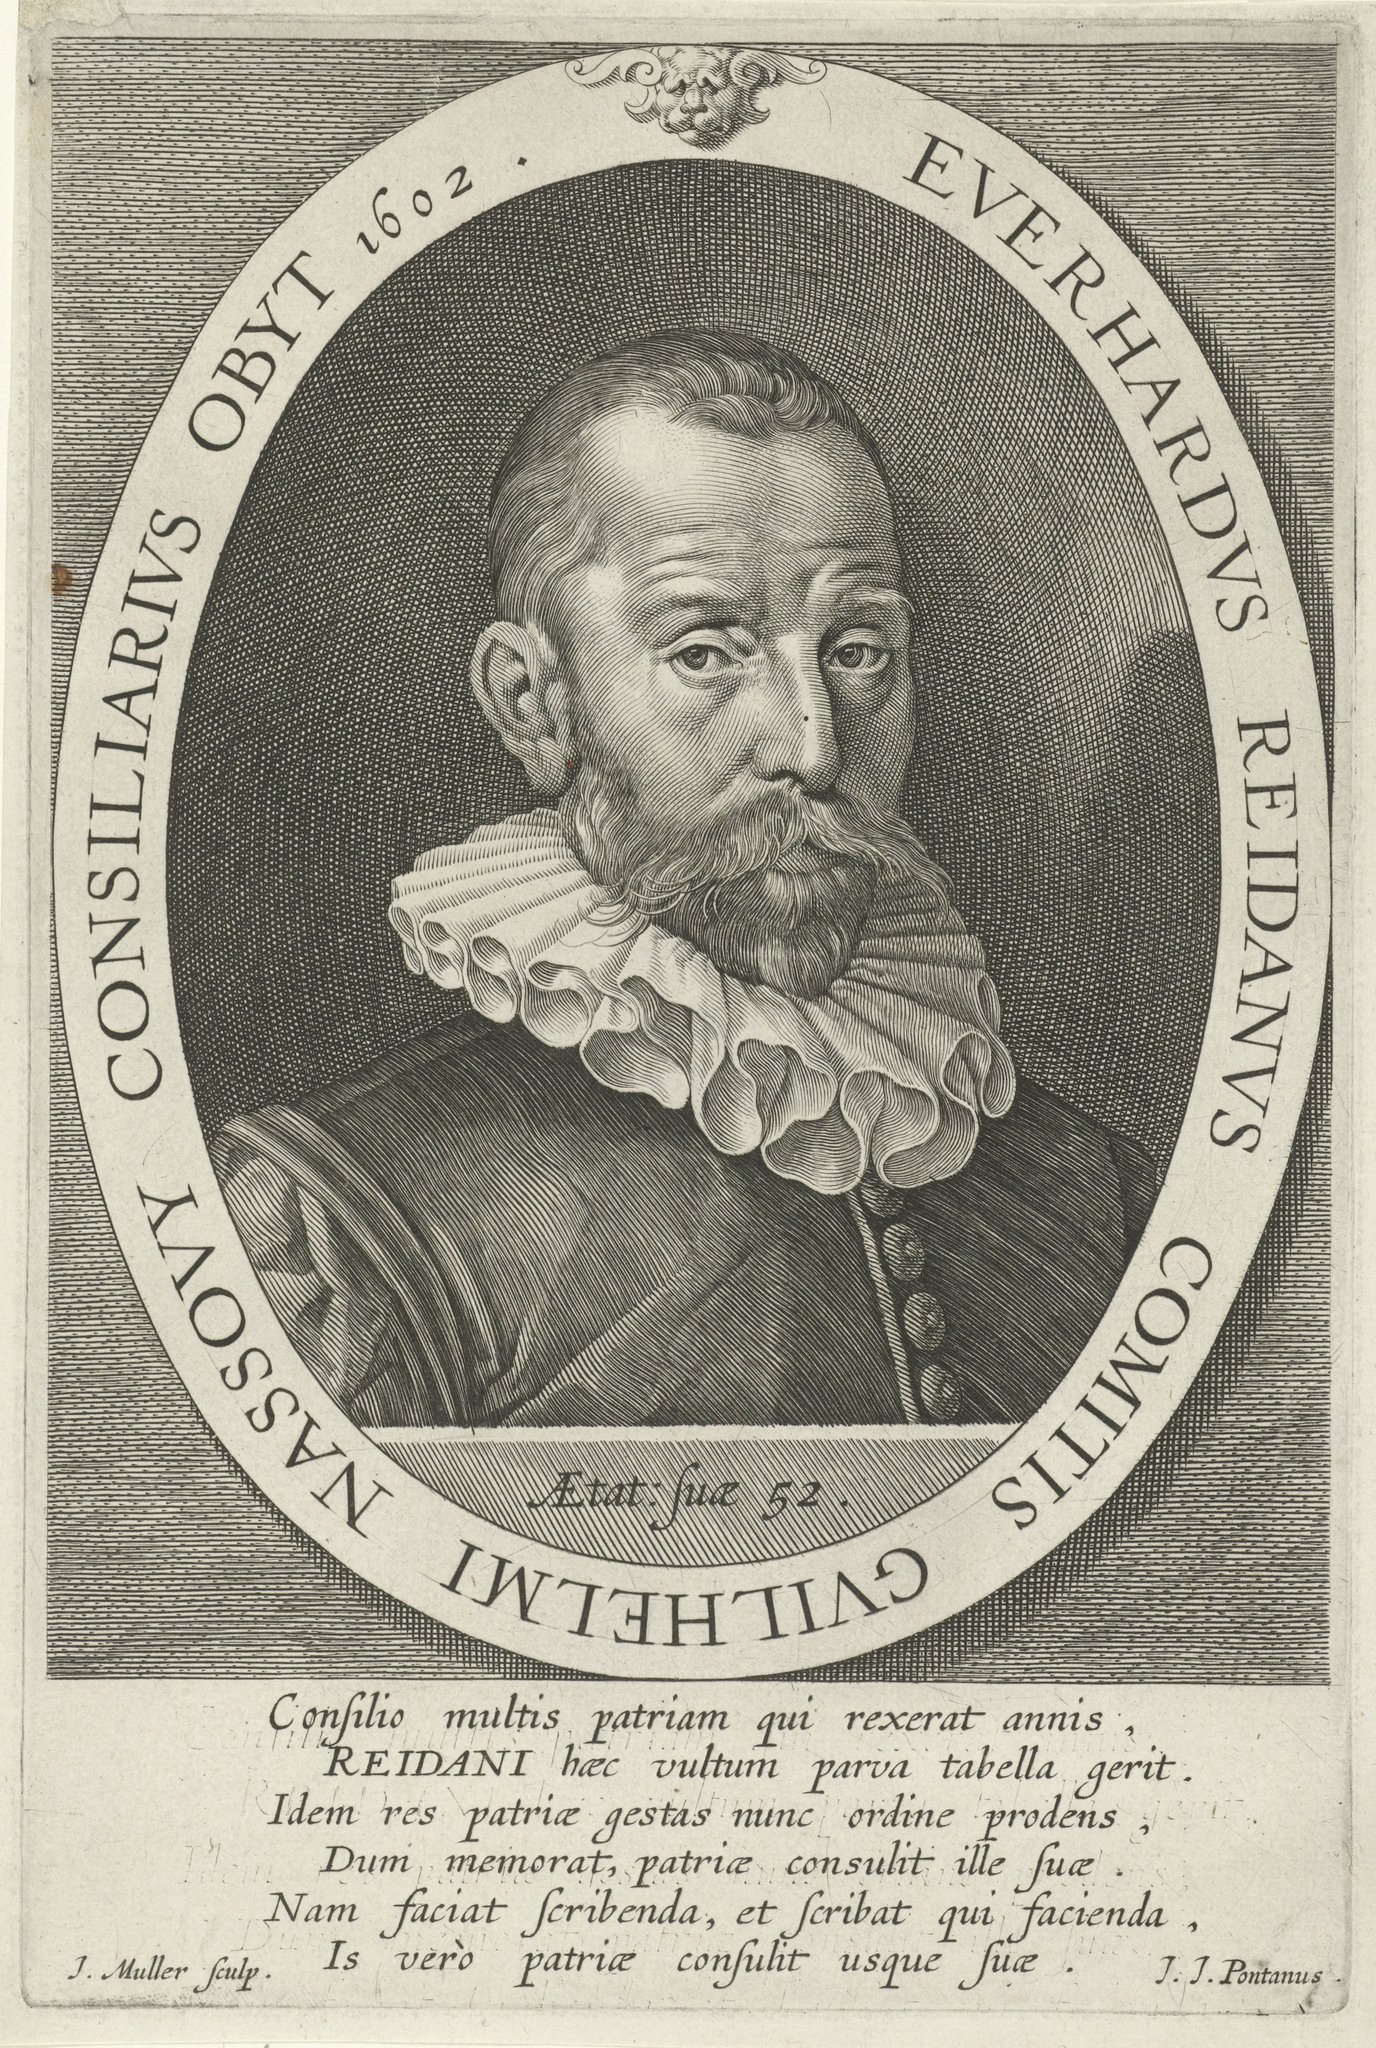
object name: print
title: Portret van Everard van Reyd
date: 1602-1604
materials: paper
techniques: engraving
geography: amsterdam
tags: deventer, everard van reyd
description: Portret van Everard van Reyd, raadgever van Willem van Oranje. Bovenaan de lijst een ornamenteel leeuwenmasker. Onderaan in de marge een zesregelig vers in het Latijn.